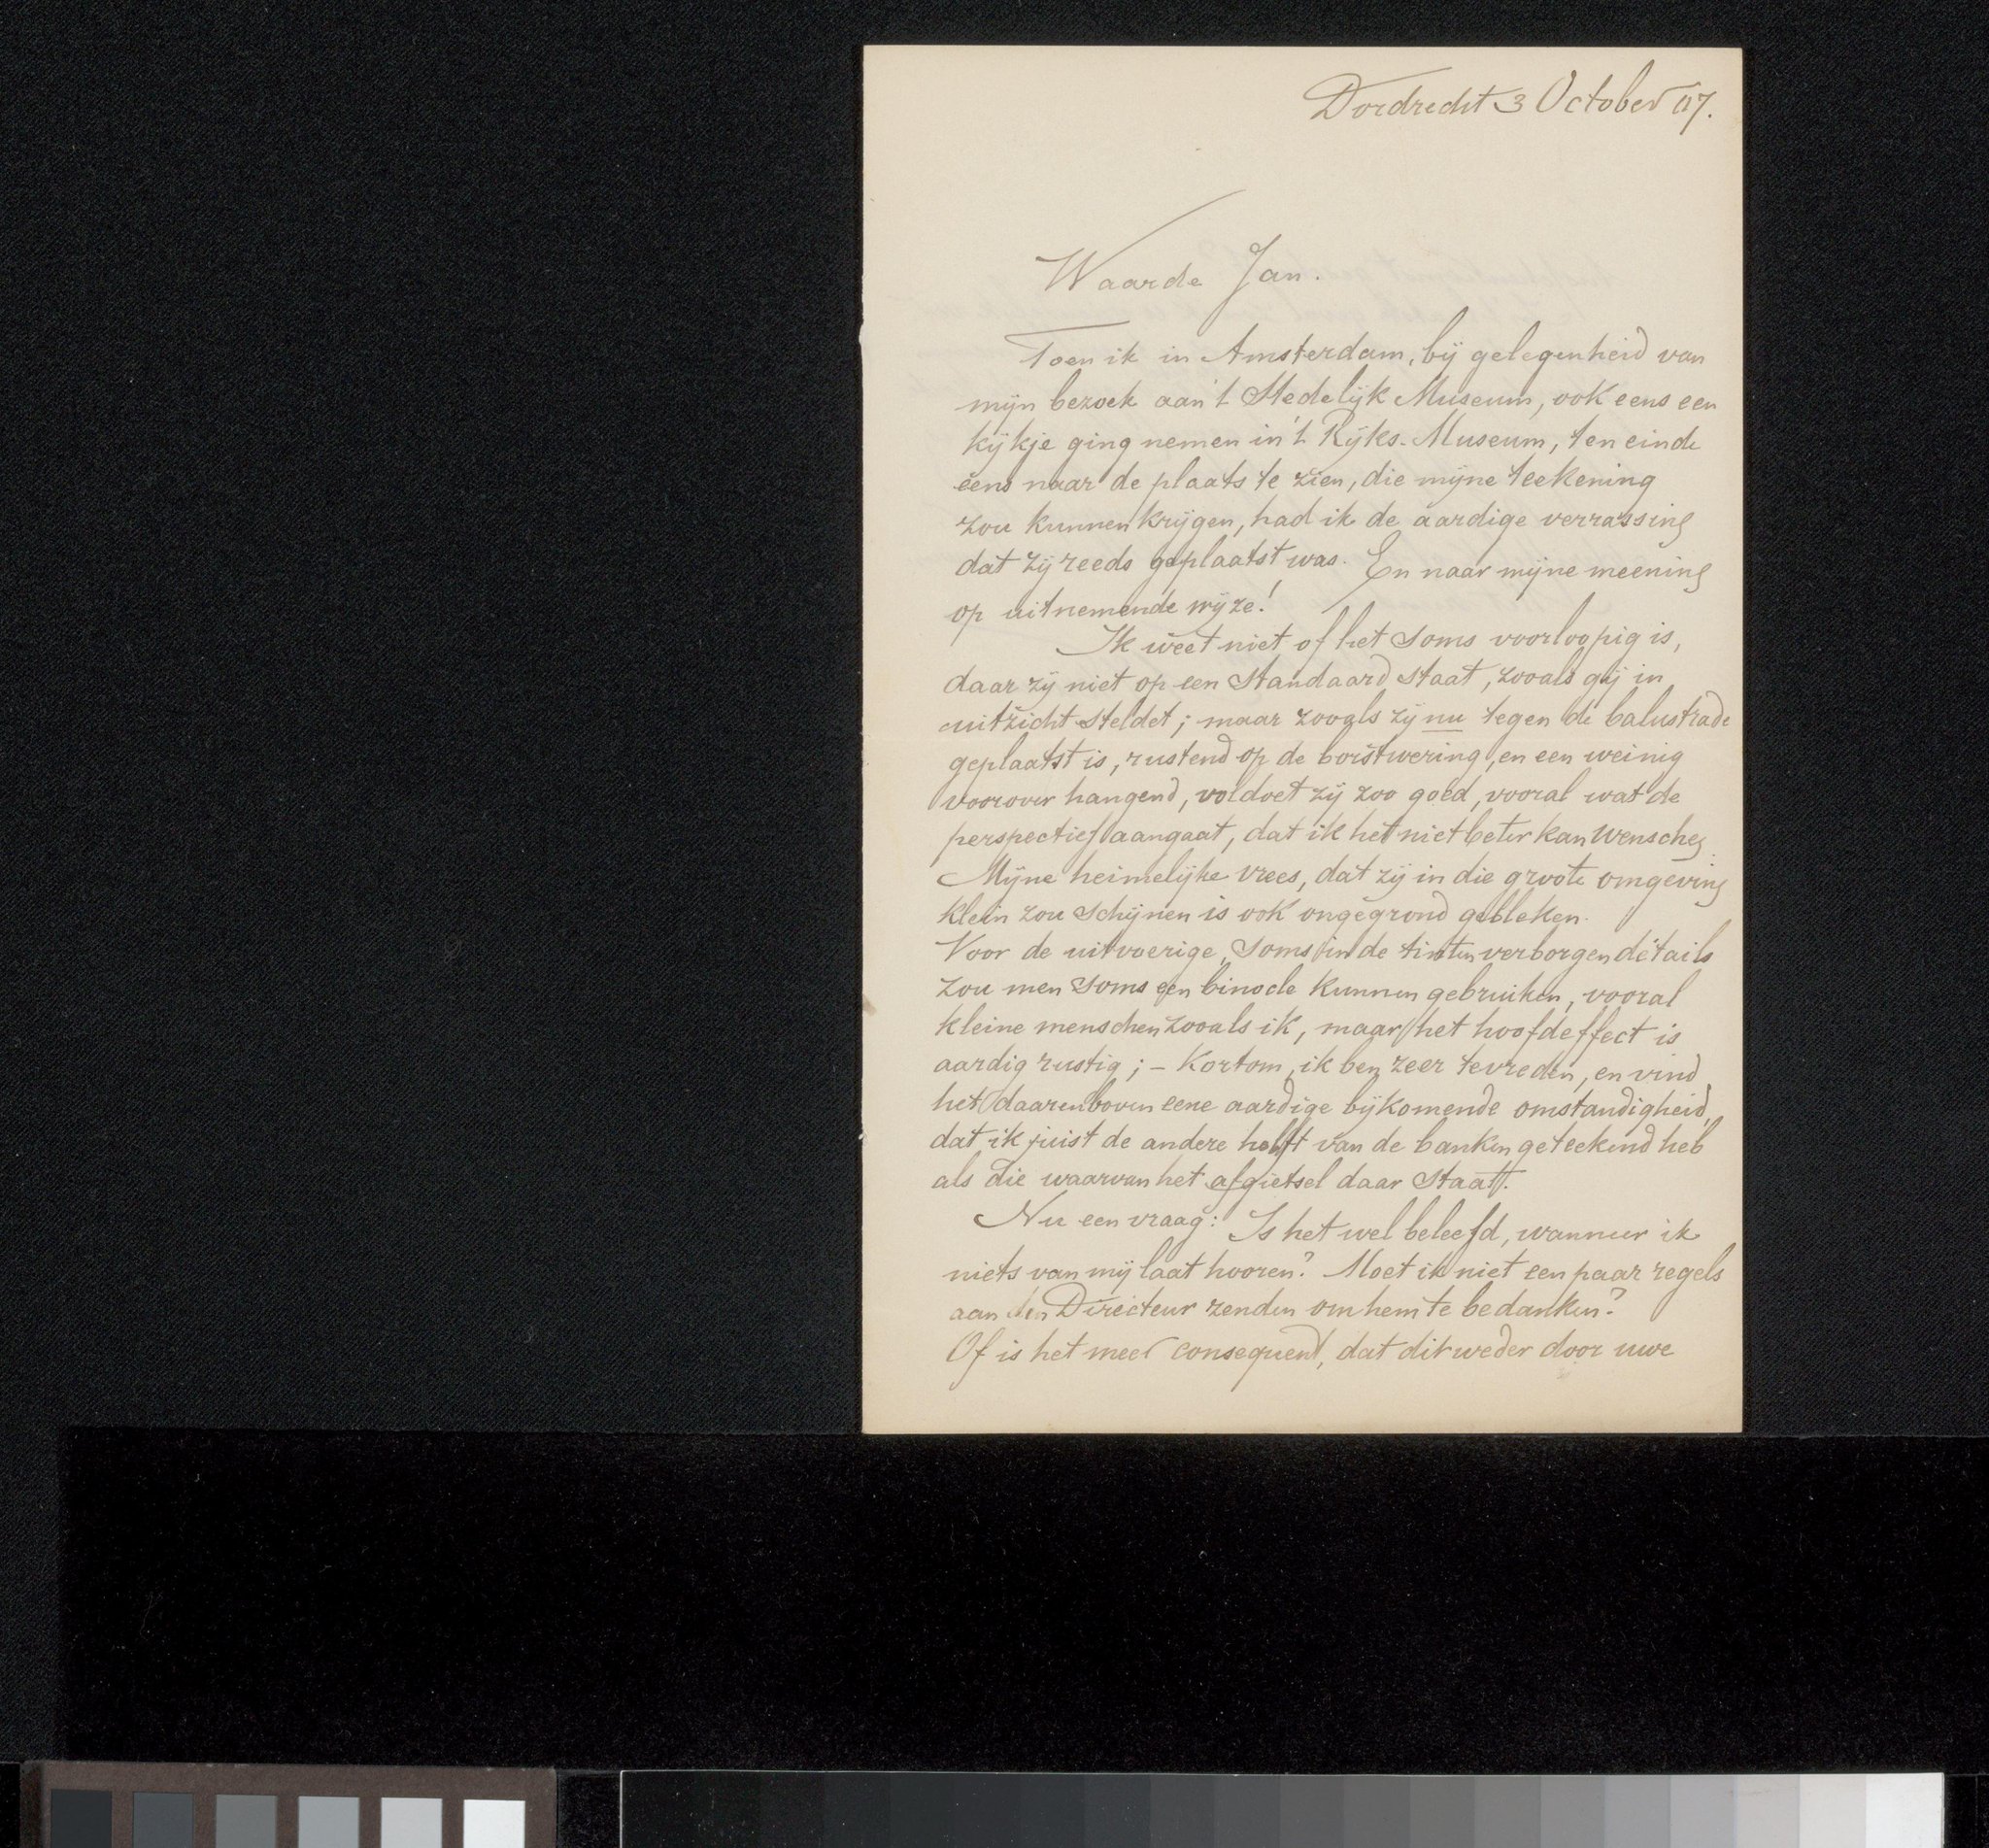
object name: letter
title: Brief aan Jan Veth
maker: adrianus jacobus terwen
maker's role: print maker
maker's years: 1841-1918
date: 1907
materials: ink, paper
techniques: pen, writing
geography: dordrecht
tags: amsterdam, painter, draughtsman, designer, jan veth, rijksmuseum amsterdam, drawing, exhibition ~ art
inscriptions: watermark, collector's mark: ‘RPK’